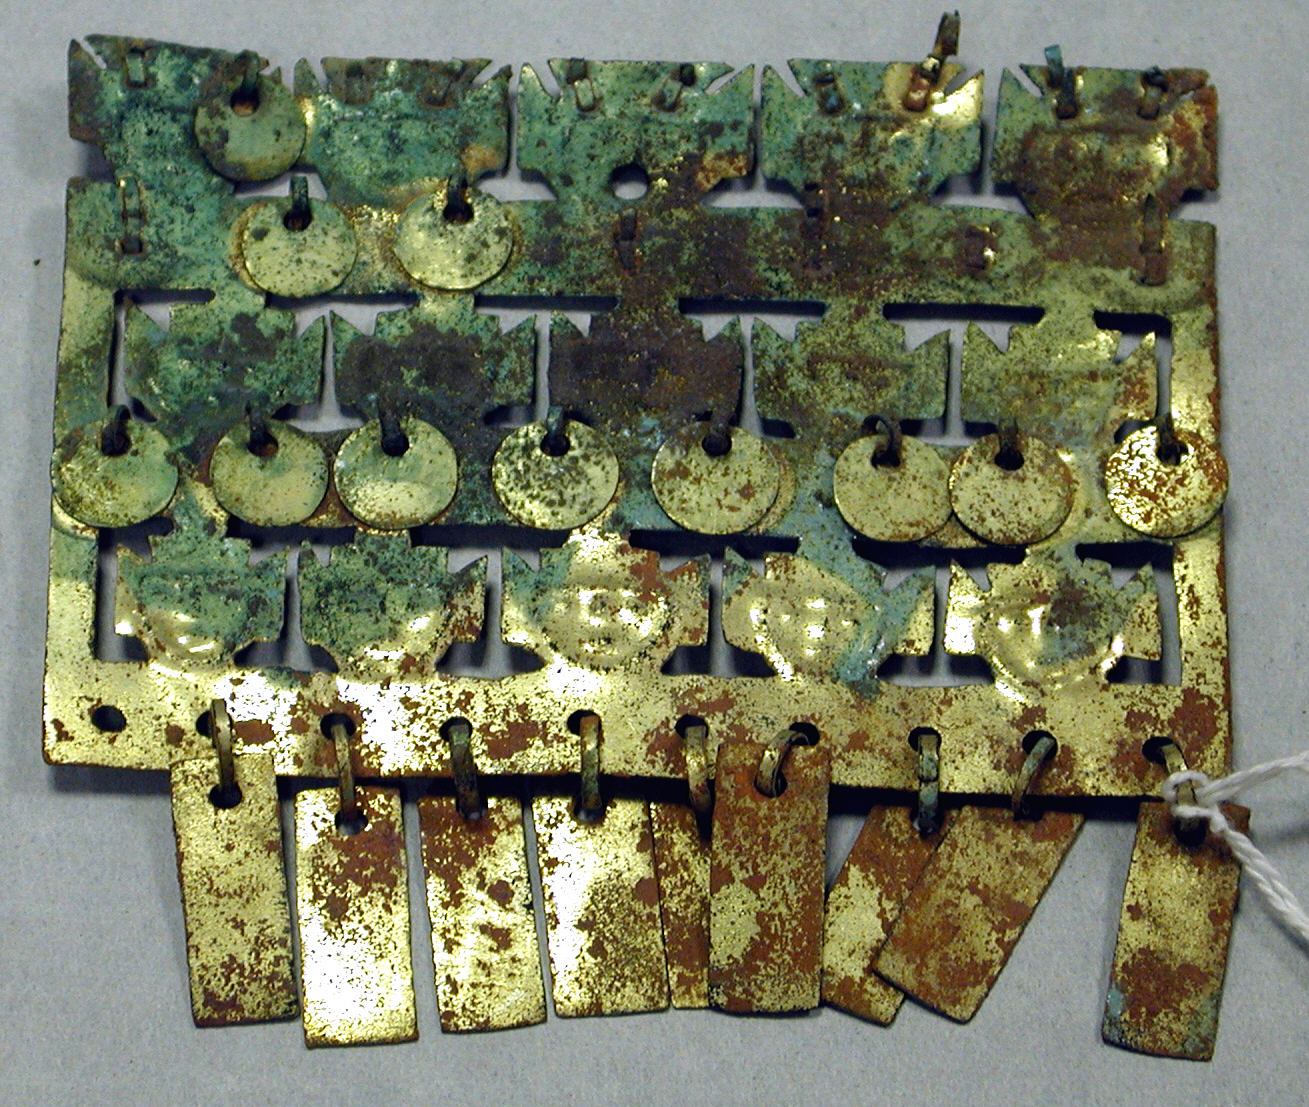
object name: ornament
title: Copper Face Ornament with Dangles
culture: vicús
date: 300 BCE-200 CE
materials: copper, gilt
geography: peru